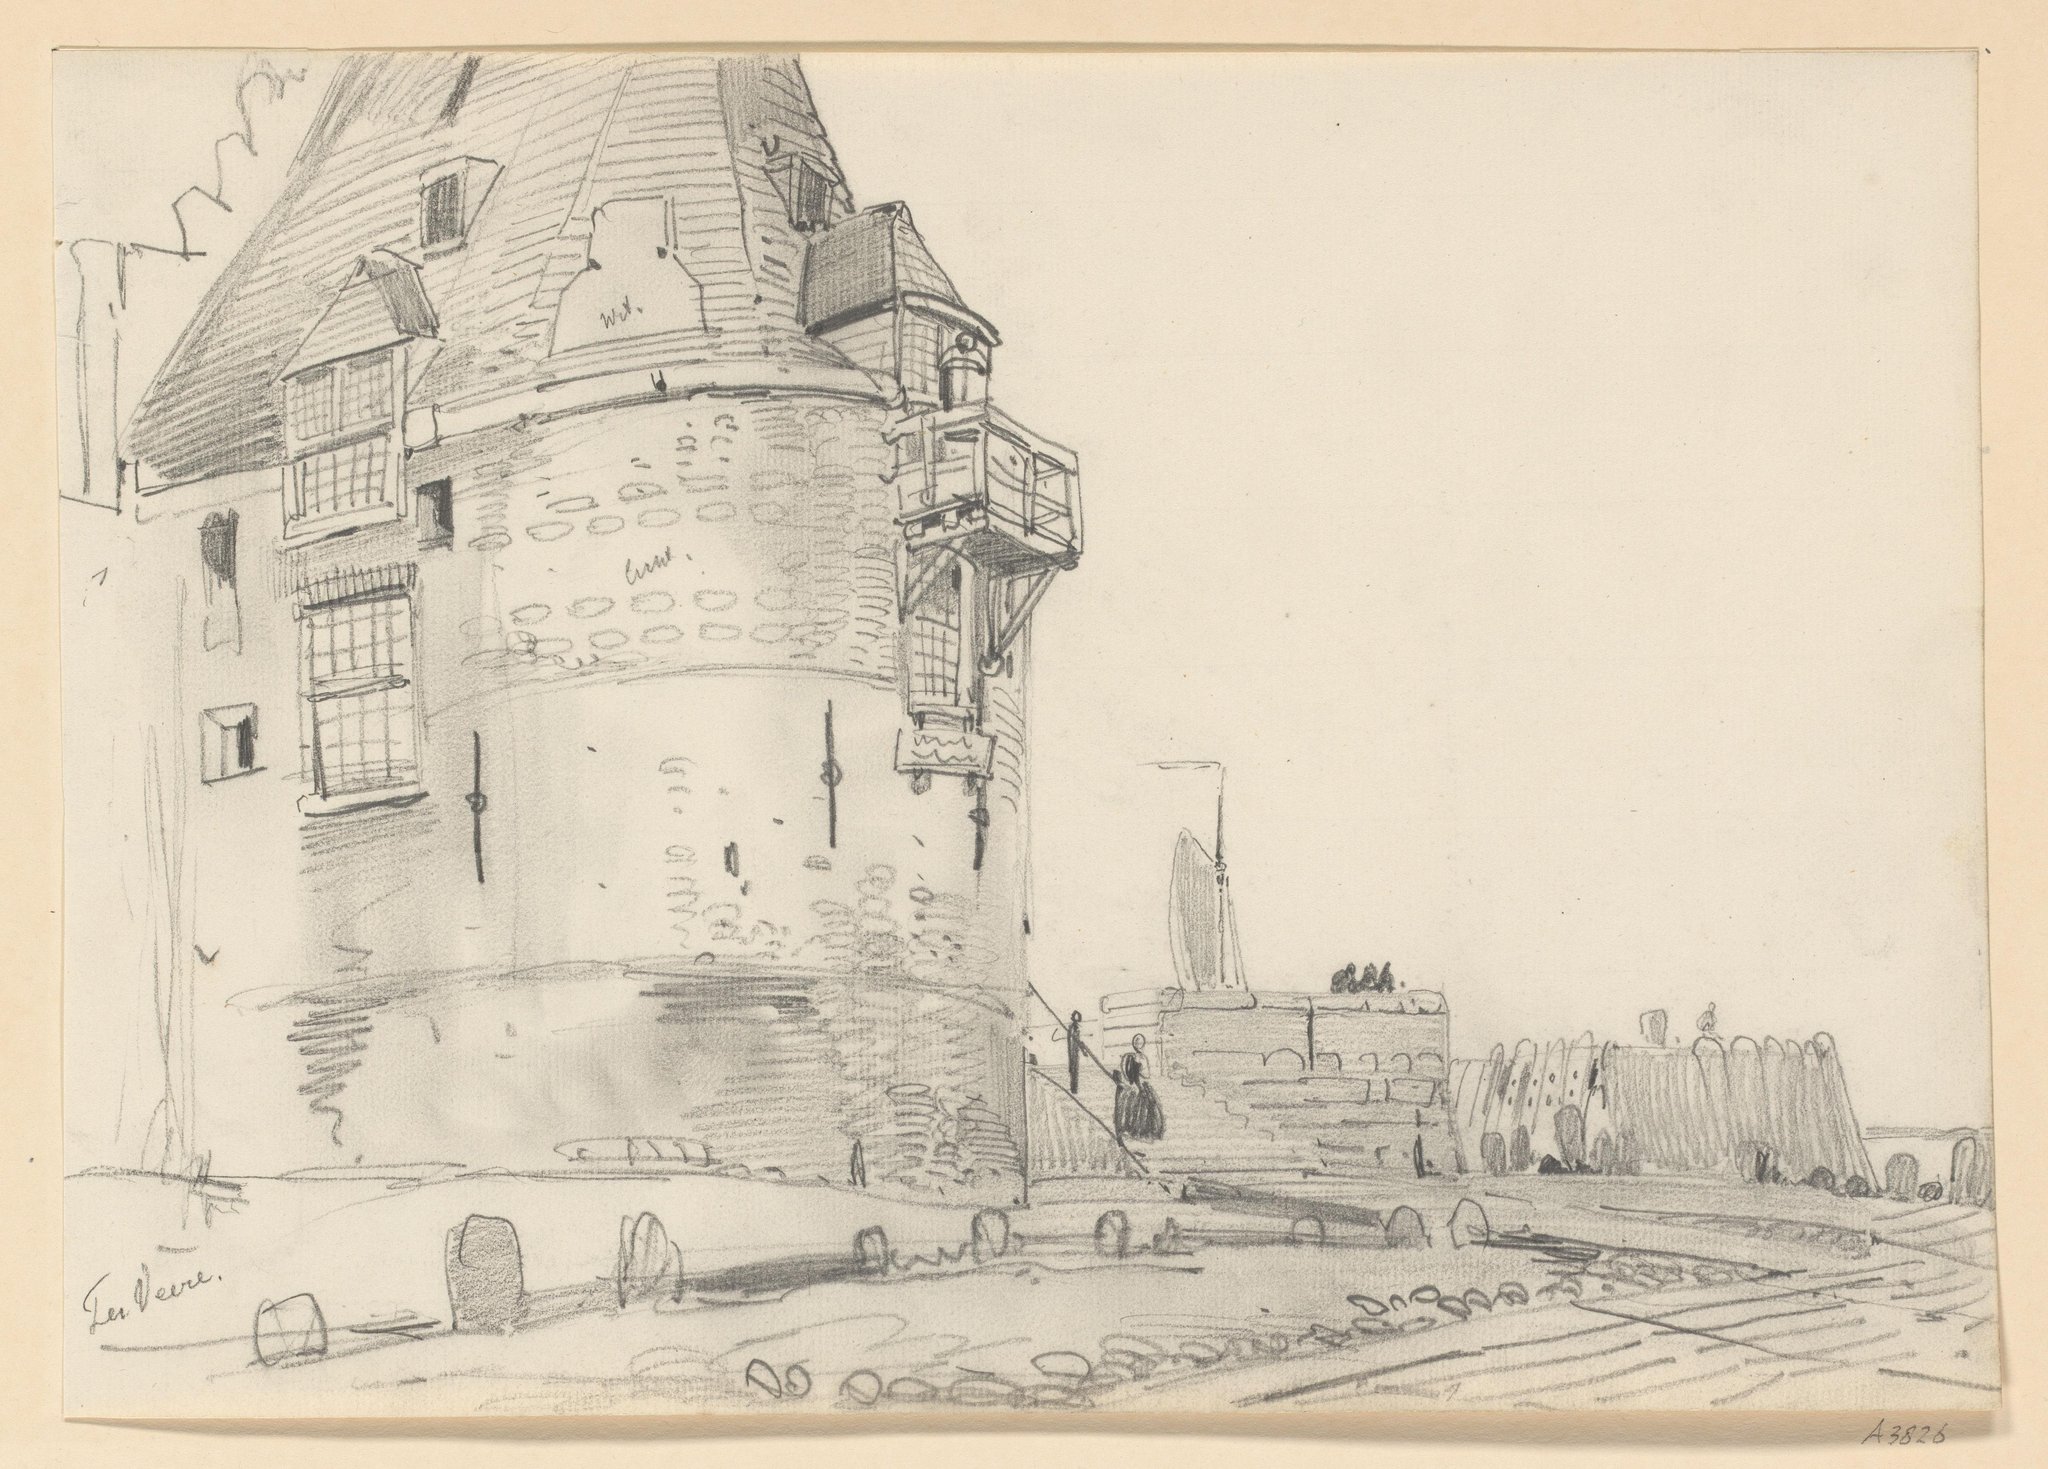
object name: drawing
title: Gebouw te Veere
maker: willem anthonie van deventer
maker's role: draughtsman, painter, print maker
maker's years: 1824-1893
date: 1834-1893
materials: paper, pencil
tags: public road